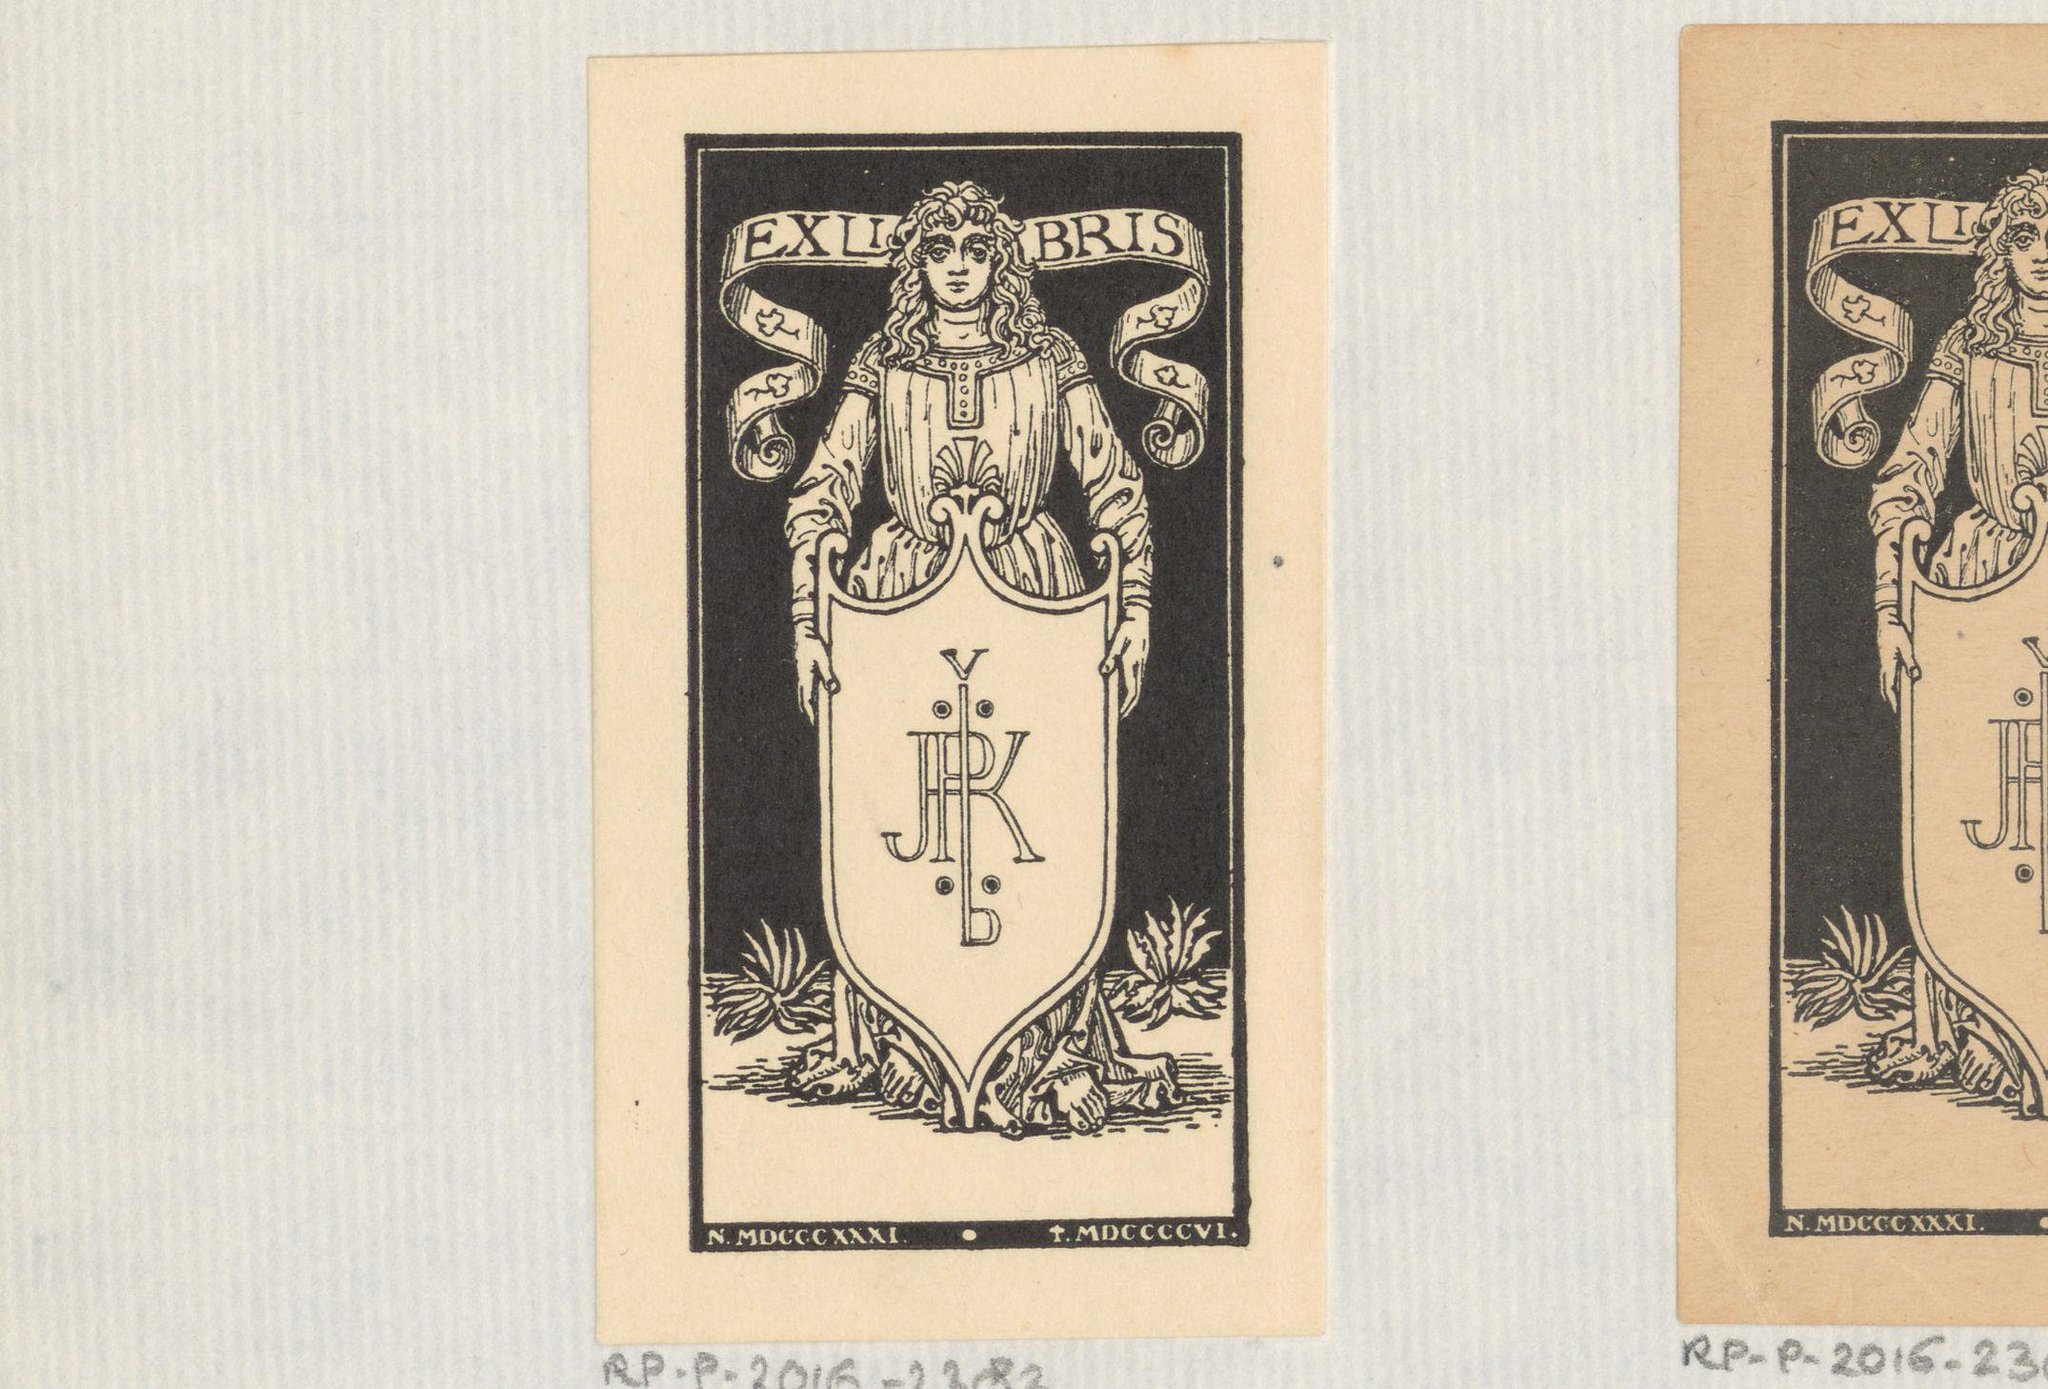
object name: bookplate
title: Ex libris van J.Ph. van der Kellen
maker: Anonymous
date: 1850-1906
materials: paper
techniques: printing block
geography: netherlands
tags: utrecht, print maker, draughtsman, johan philip van der kellen, shield-bearer, squire, youth, adolescent, historical costume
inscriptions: collector's mark: Lugt 2228